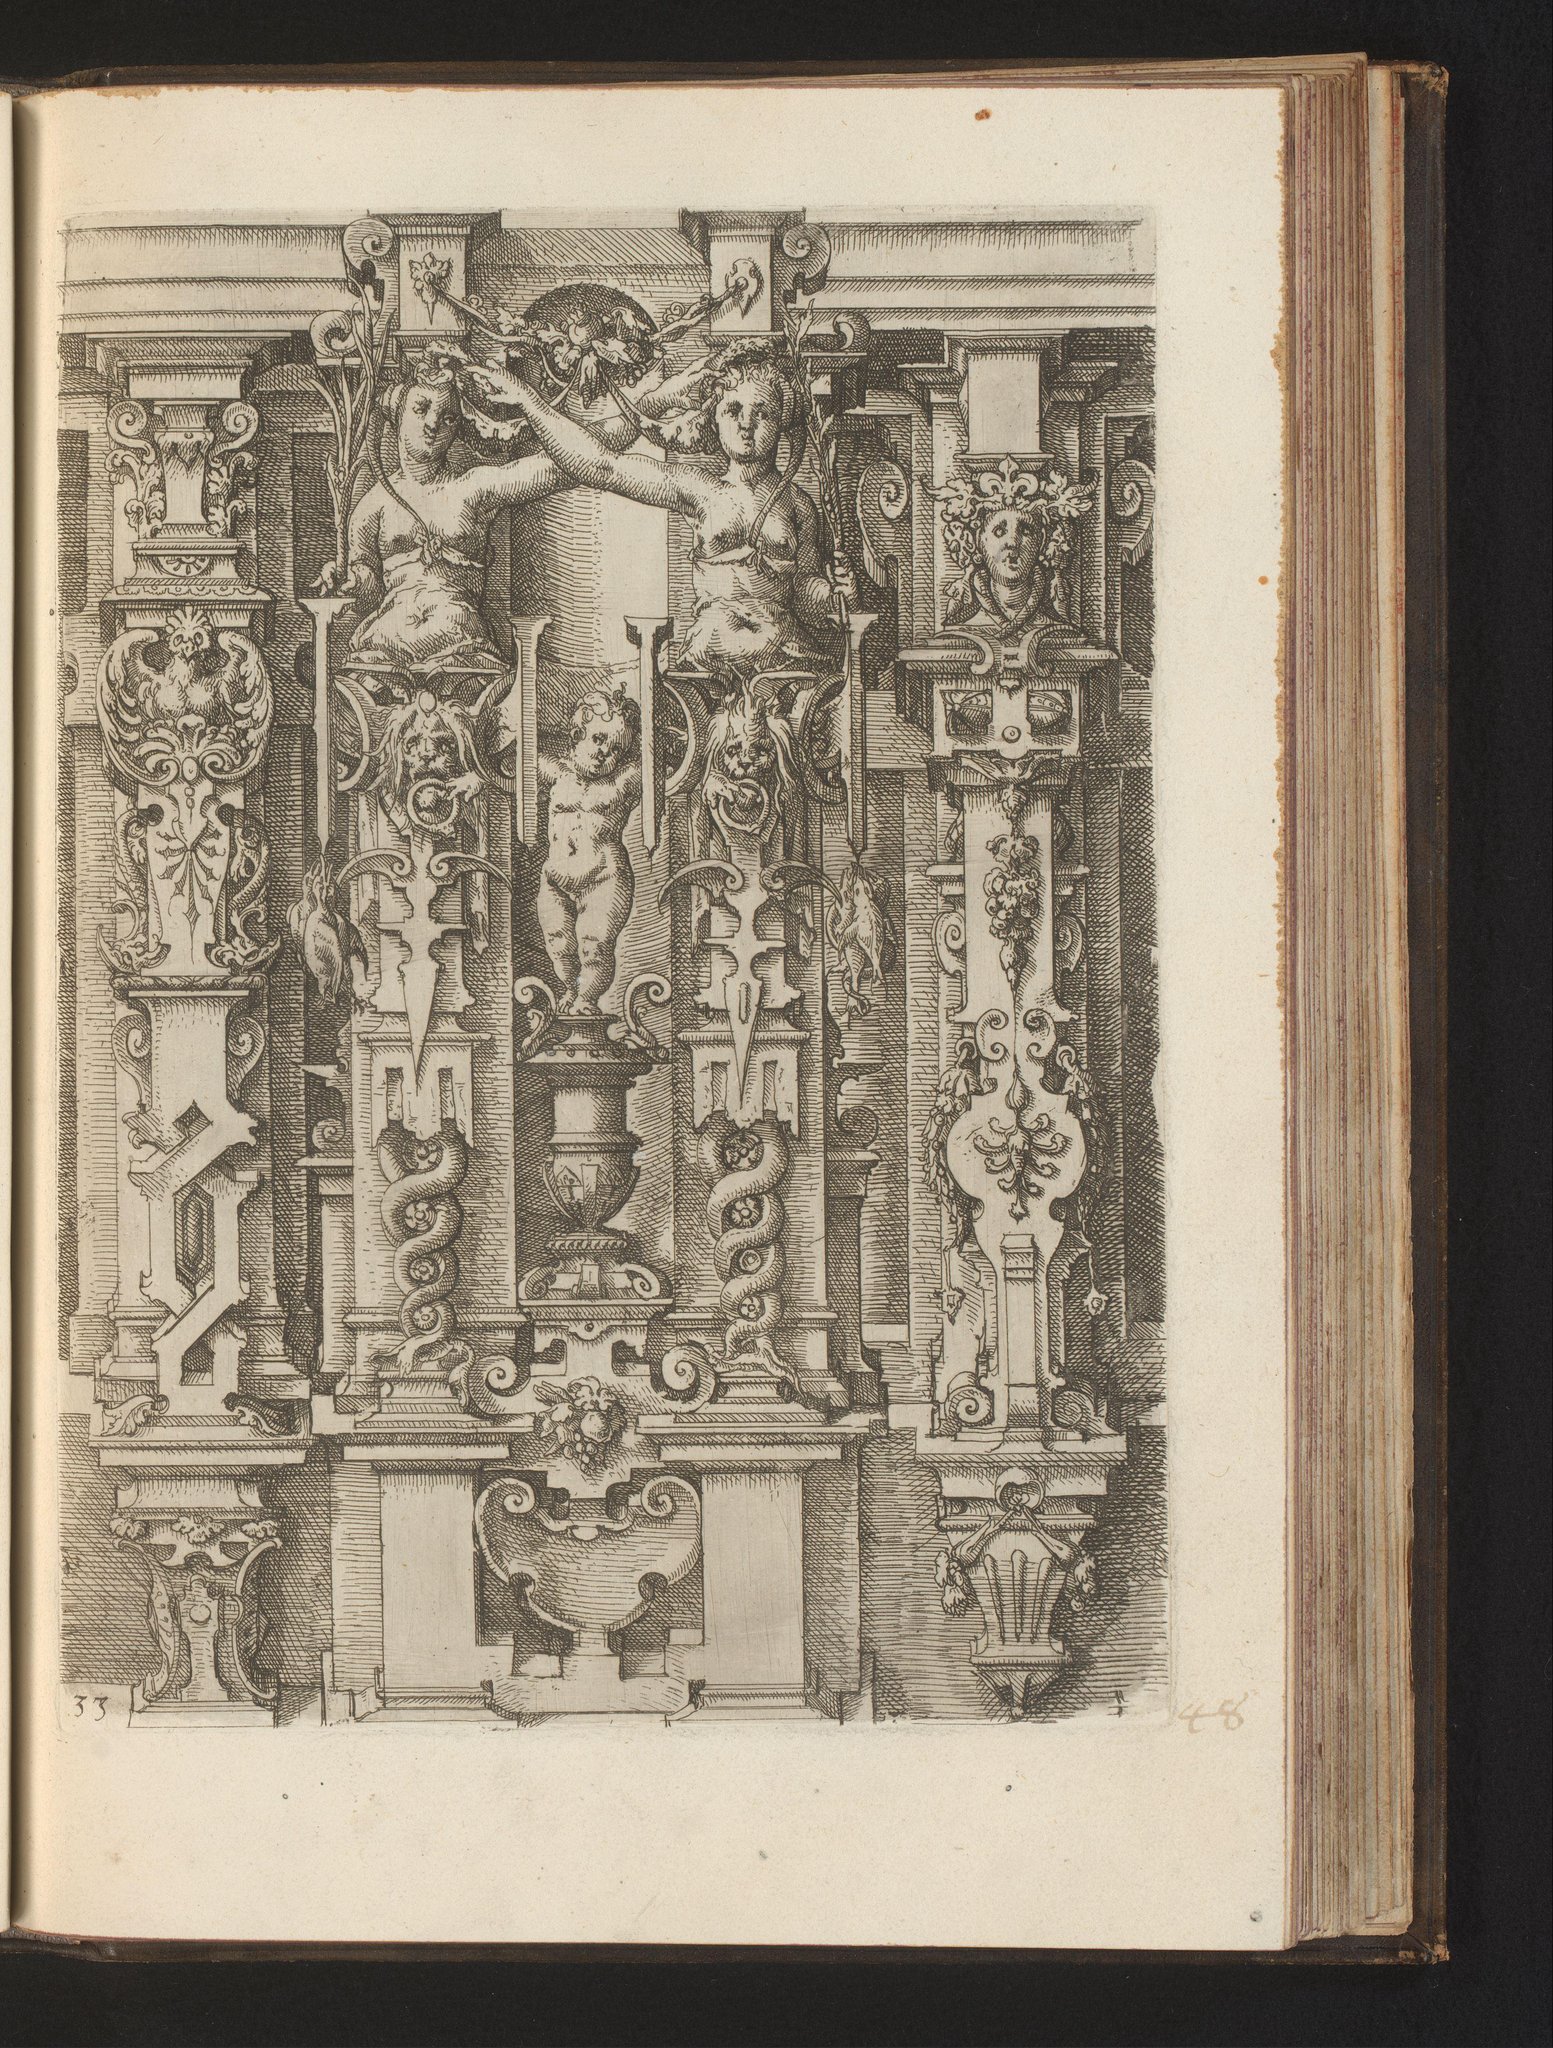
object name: book illustration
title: Twee composiete pilasters, twee vrouwelijke hermen en een vaas met daarop een kind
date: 1593-1595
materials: paper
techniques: etching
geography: straatsburg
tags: composite order ~ architecture, column, pillar ~ architecture, pedestal of a piece of sculpture (perhaps in the form of a herm) (+ architecture), other architectural details, ornament ~ festoon, garland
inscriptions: collector's mark: Lugt 2760, collector's mark: Lugt 2228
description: Prent gebruikt in: Dietterlin, Wendel (I). Architectura de quinq[ue] columnarum simmetrica distributione et variis eorundem or namentis: Liber I. Straatsburg: Bernhard Jobin, 1593.